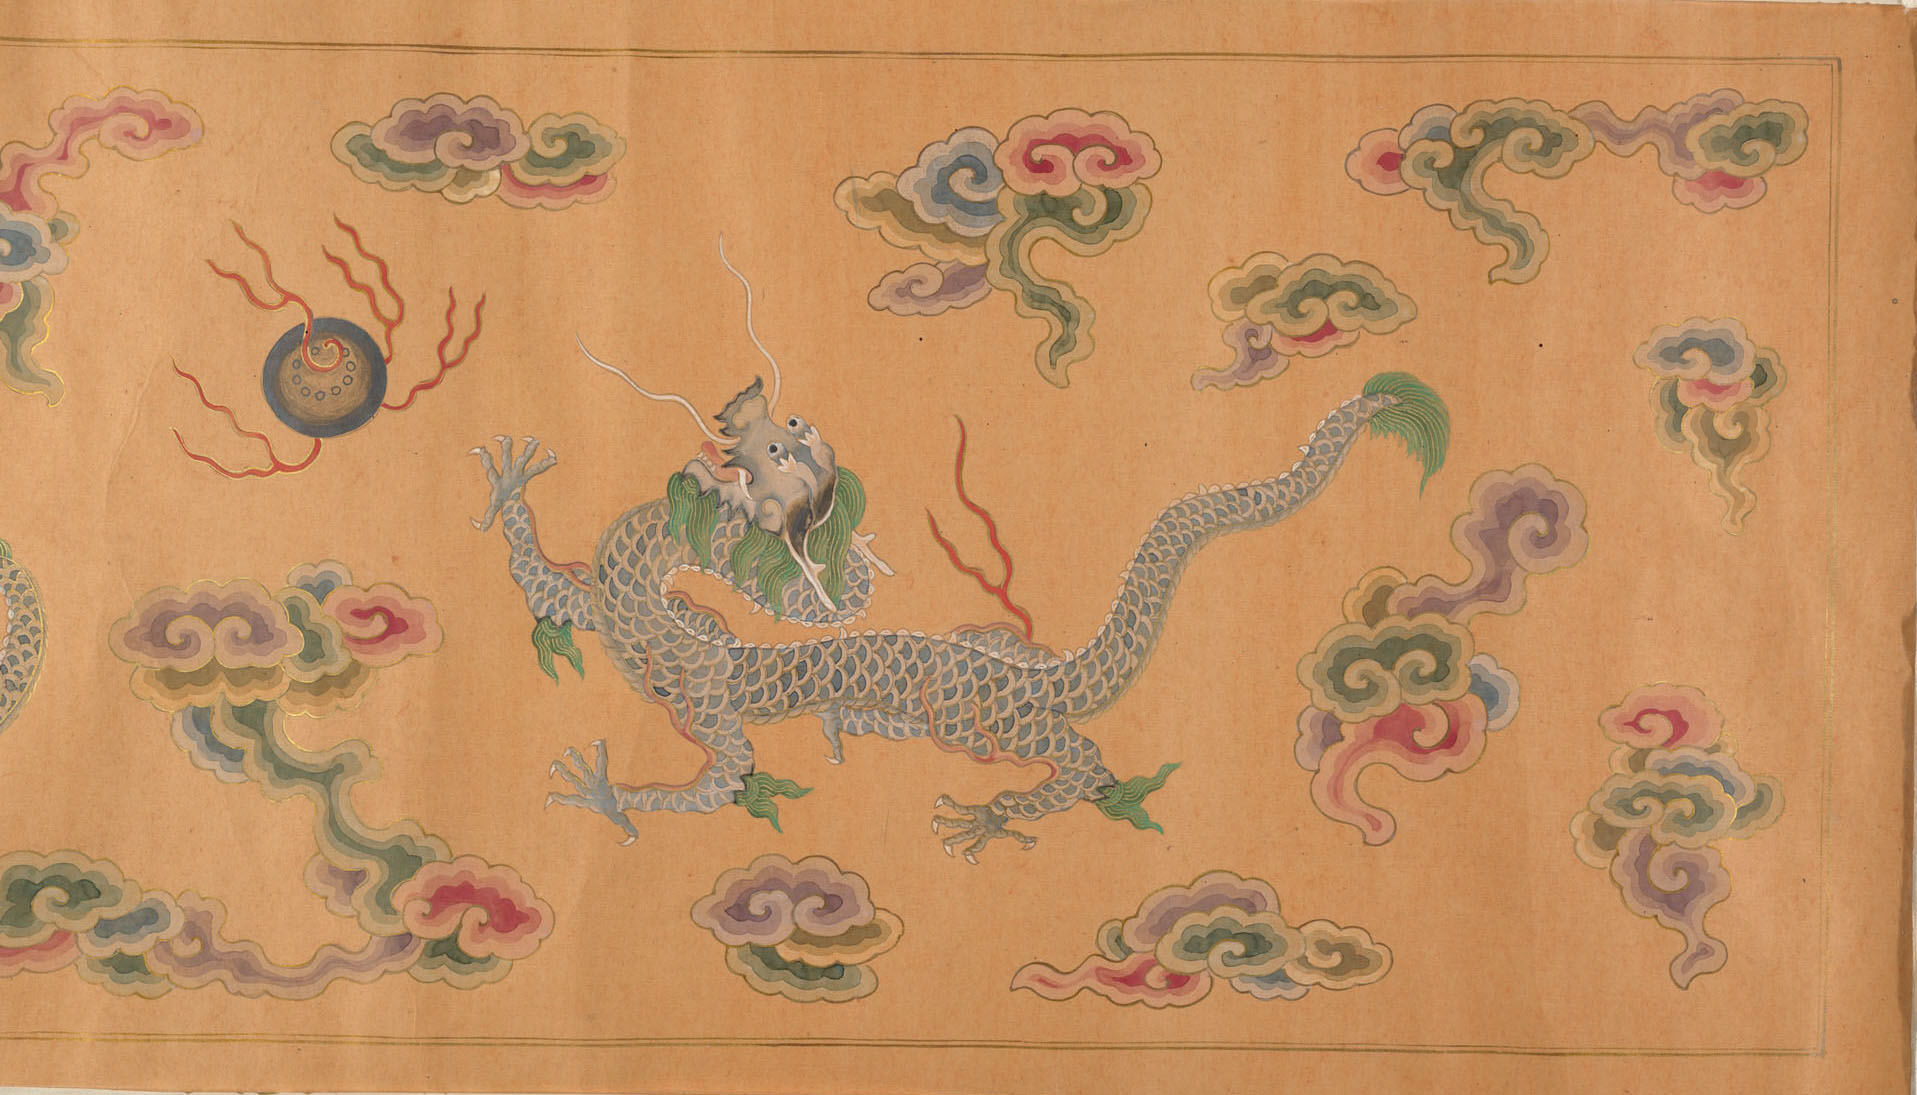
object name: handscroll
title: Varieties of Lychee Fruit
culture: chinese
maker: unidentified artist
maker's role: artist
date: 960-1279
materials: ink, silk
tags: dragons